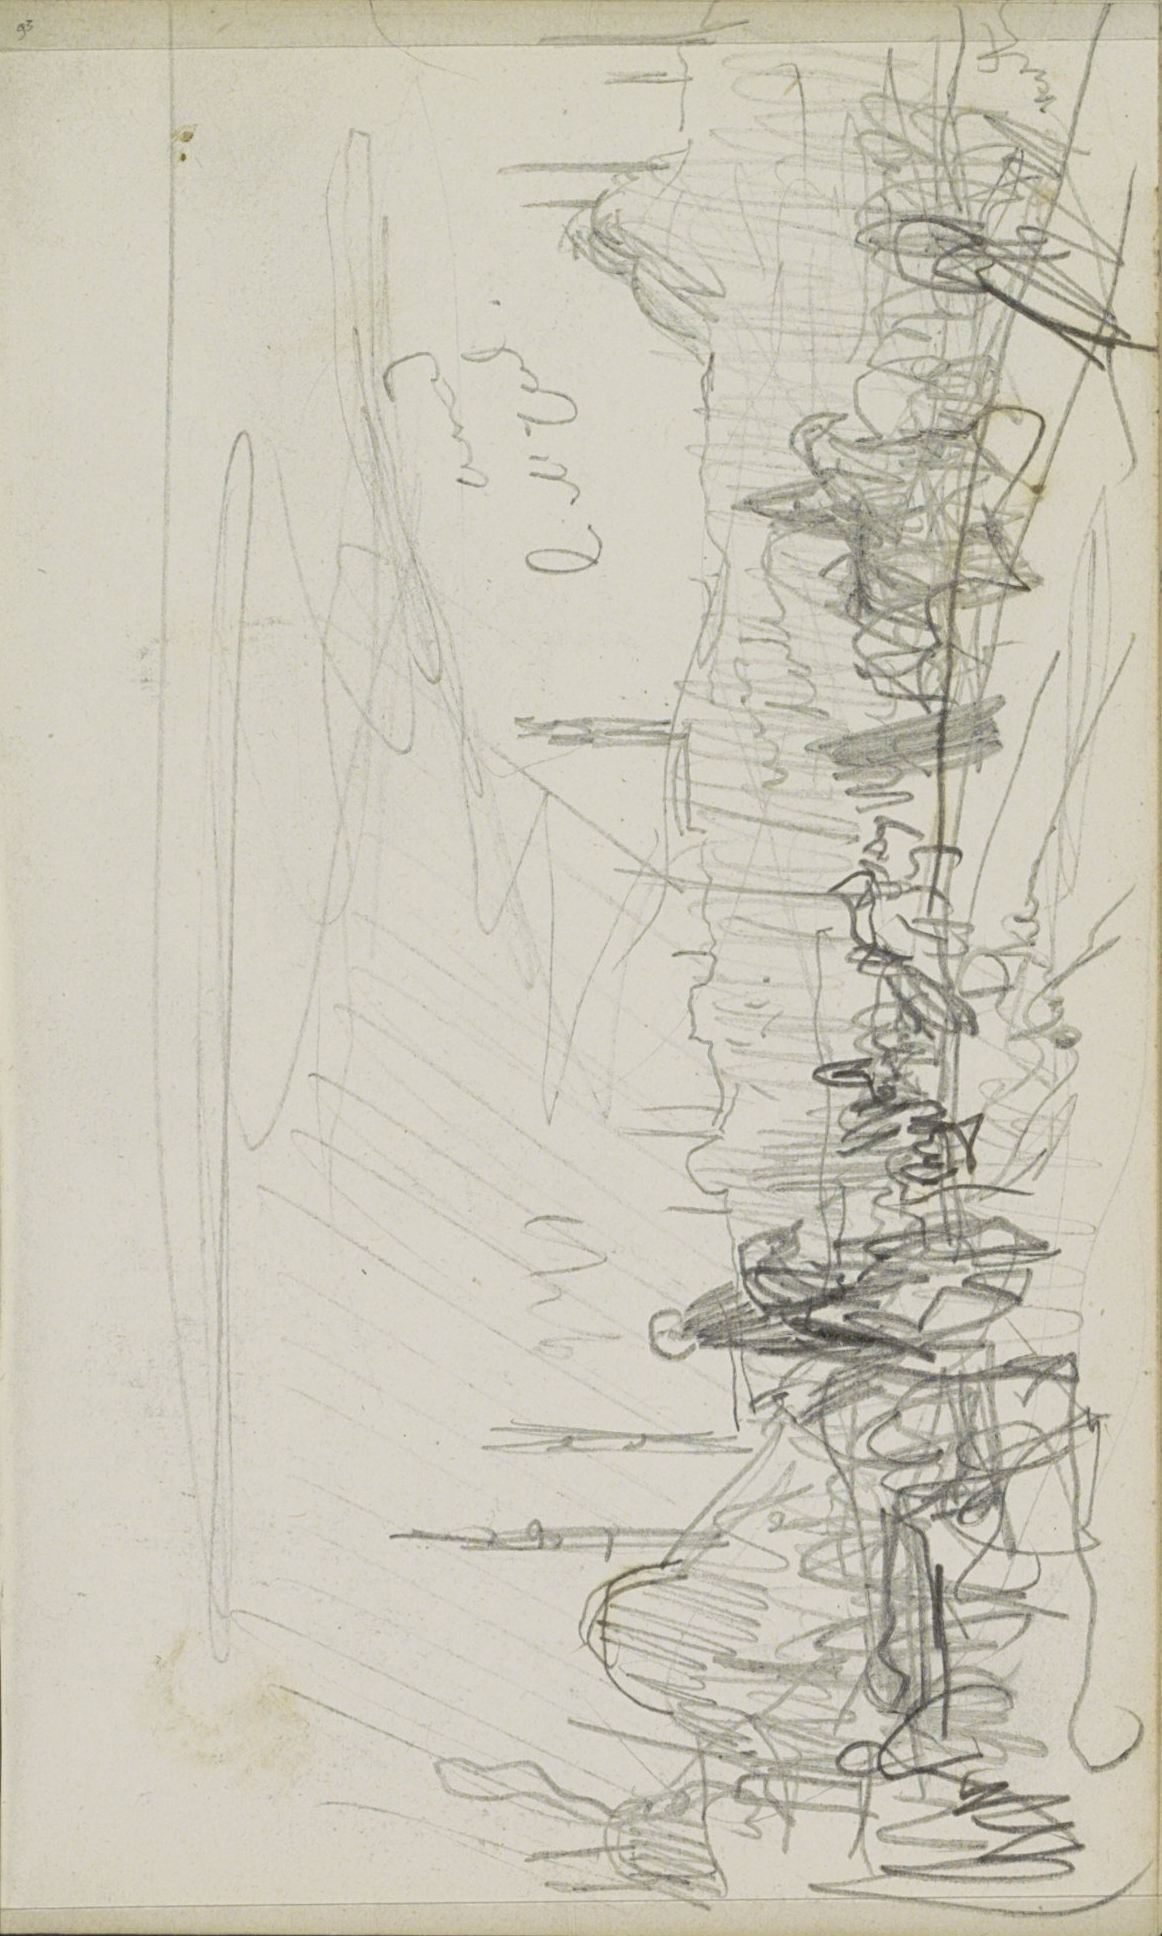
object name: sketchbook leaf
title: Gezicht op Caïro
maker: marius bauer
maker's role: draughtsman, print maker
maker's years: 1867-1932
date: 1904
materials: paper, pencil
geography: cairo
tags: city-view, and landscape with man-made constructions, africans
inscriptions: kleurnotitie, handgeschreven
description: Op de voorgrond enkele Egyptenaren op een open plek met uitzicht over de stad. Pagina 93 uit een schetsboek met 56 bladen.